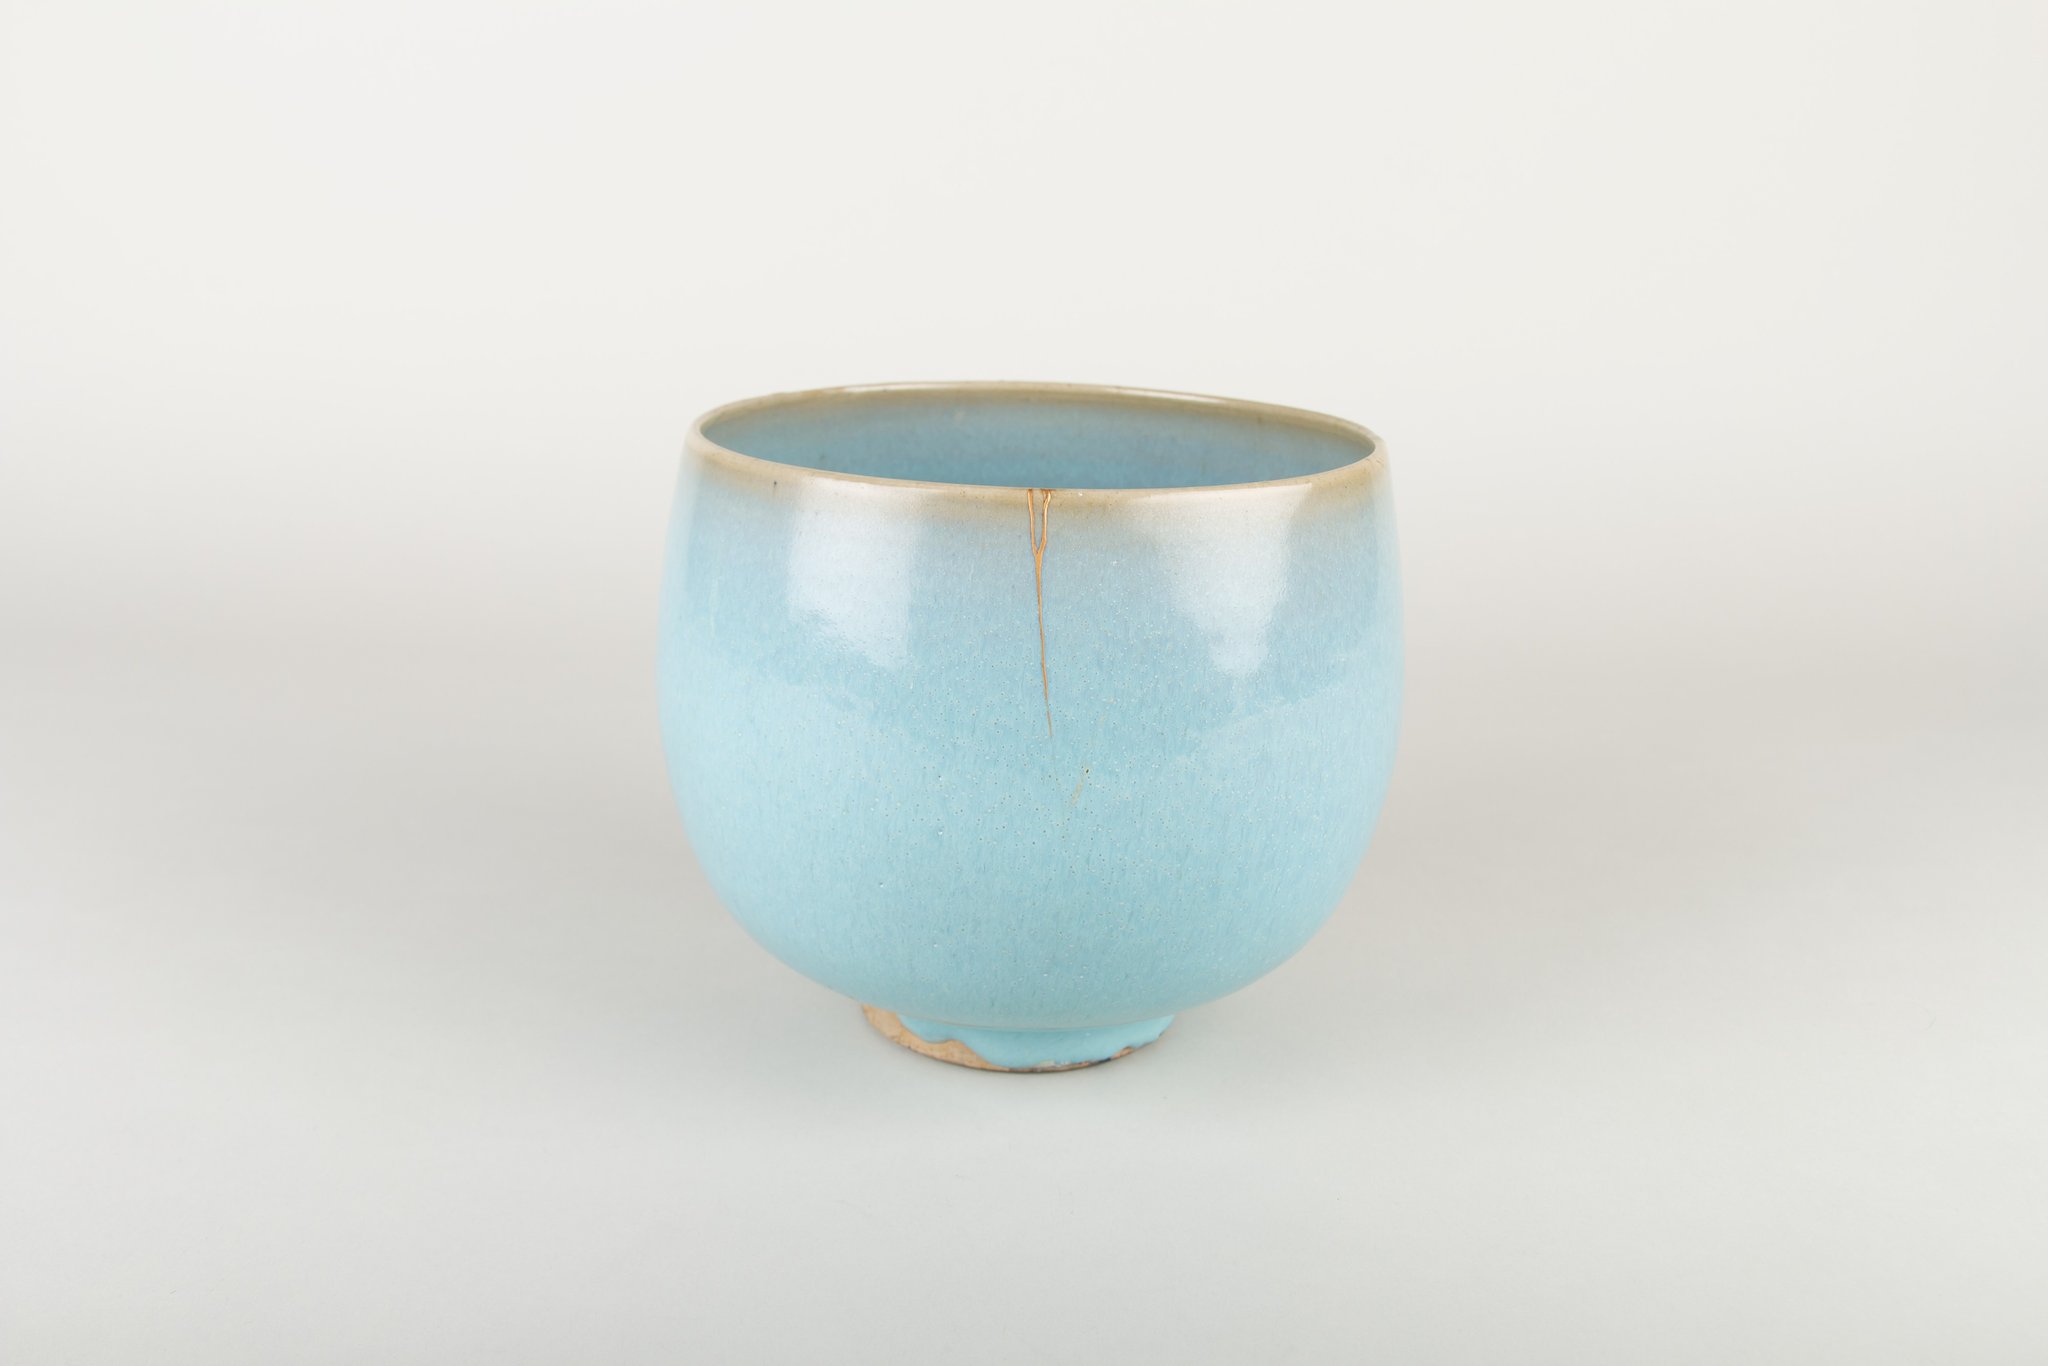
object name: bowl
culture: chinese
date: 1167-1300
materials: glaze, stoneware